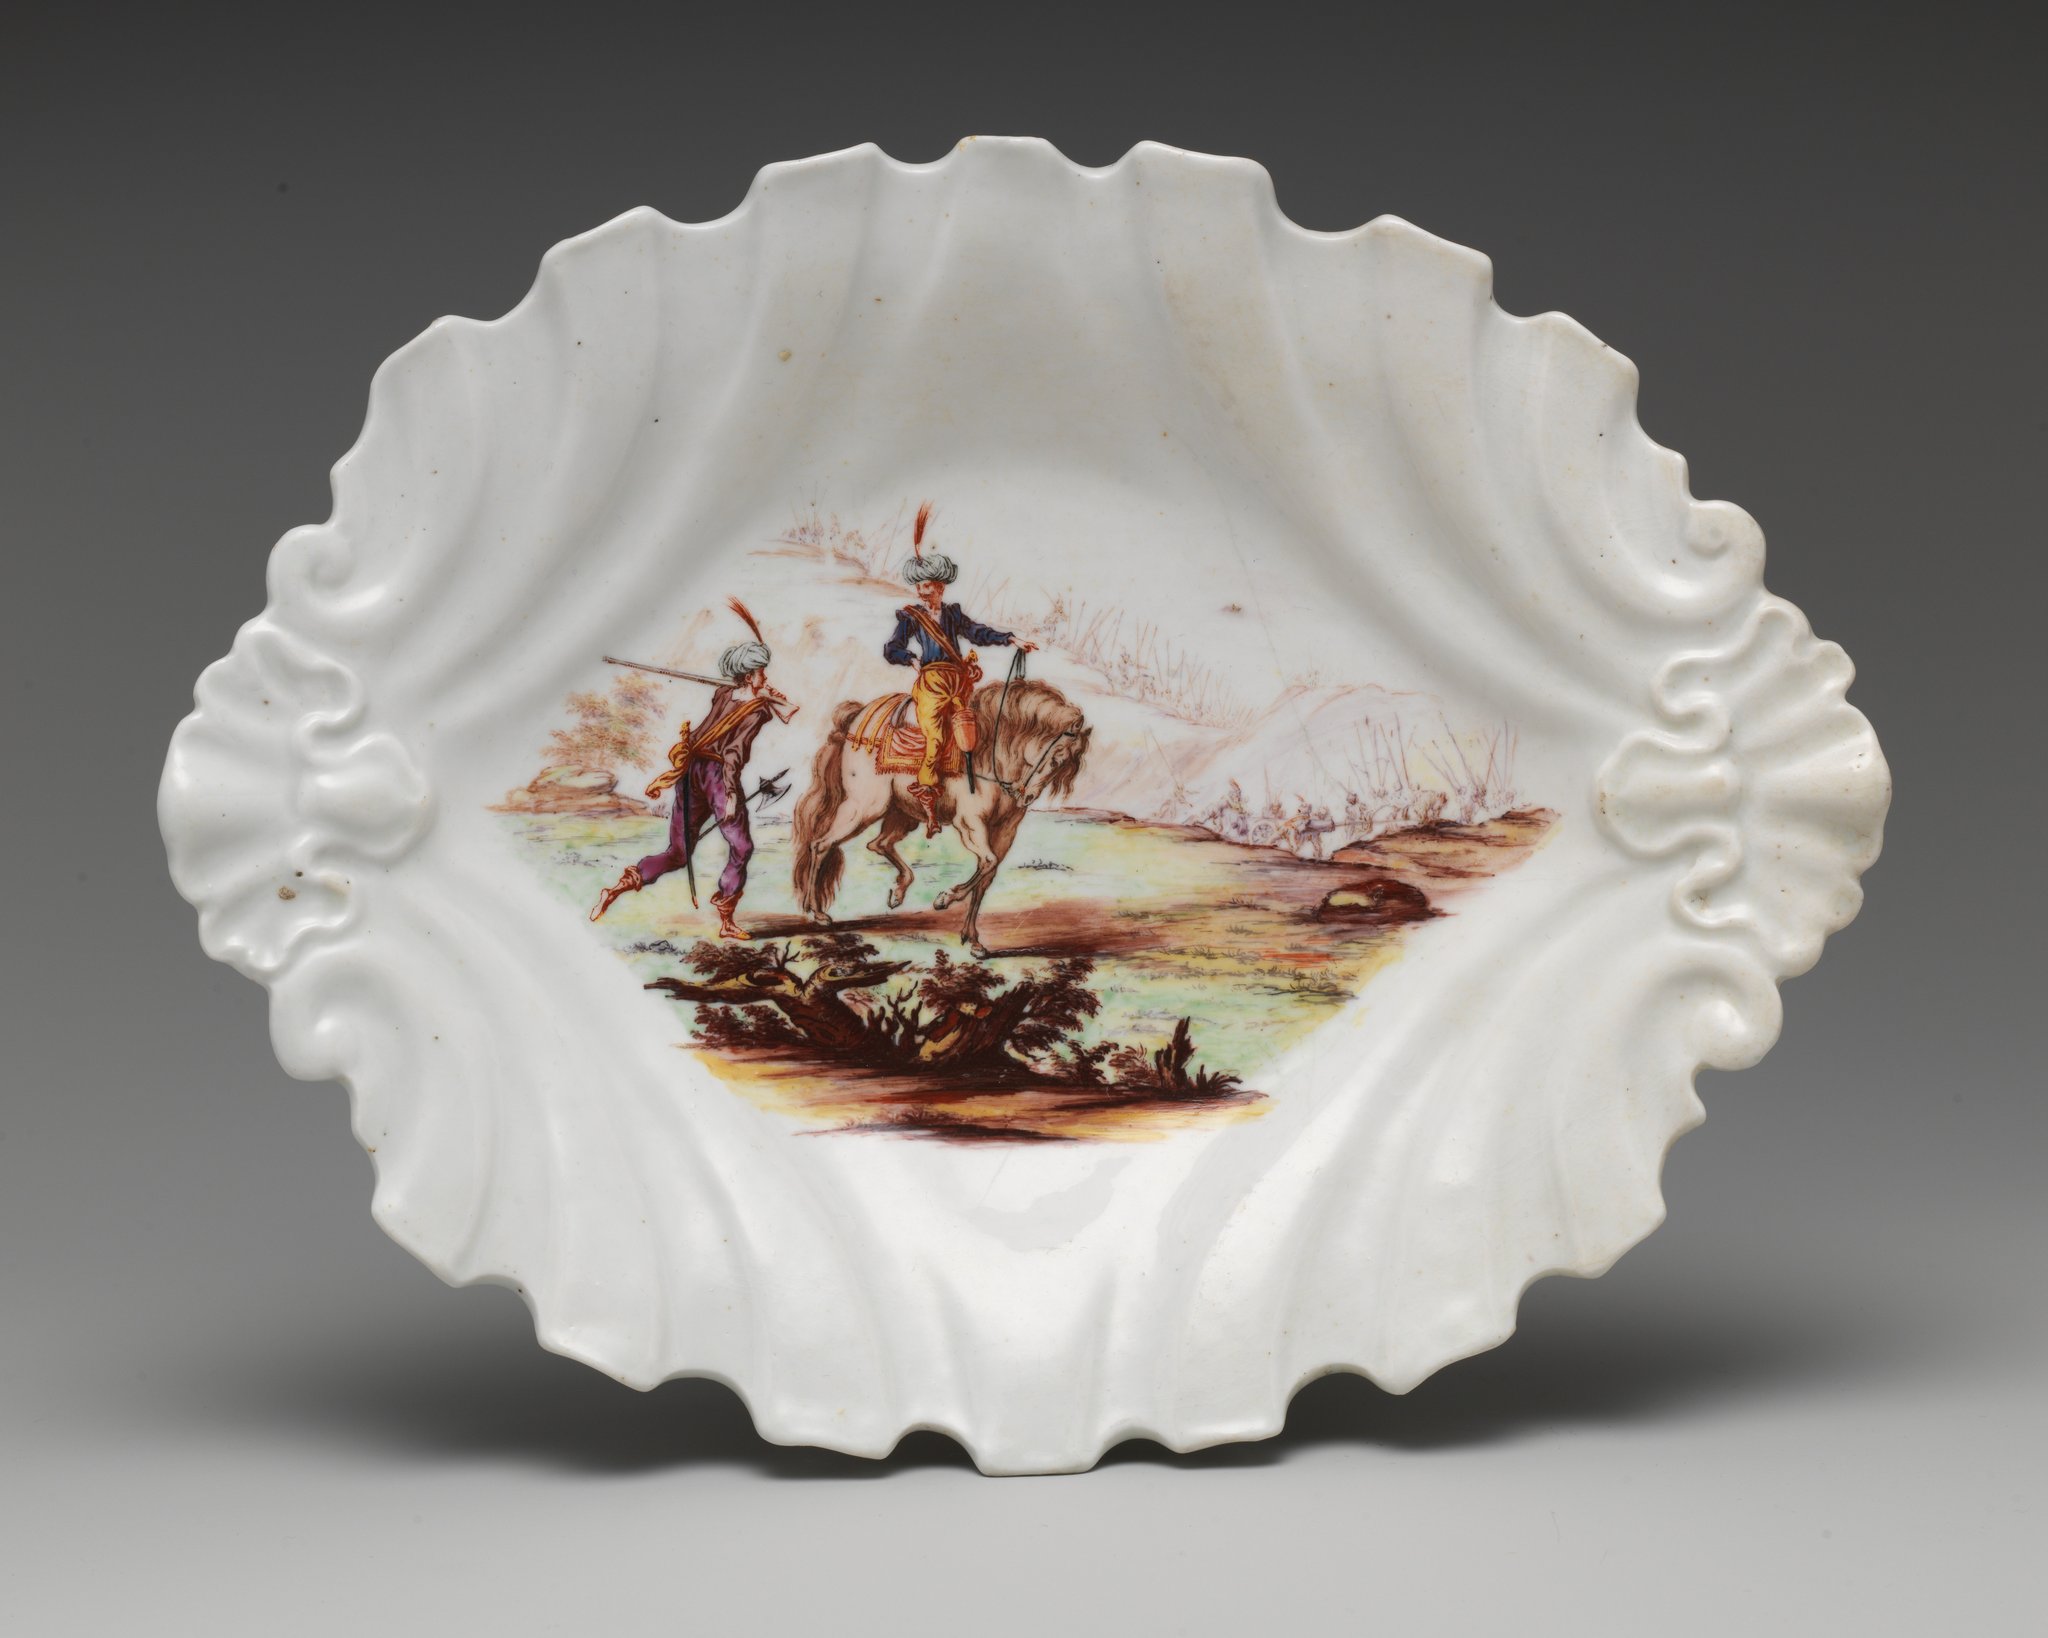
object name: dish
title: Dish (part of a set)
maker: chelsea porcelain manufactory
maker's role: factory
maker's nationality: british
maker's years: 1744-1784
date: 1752-1755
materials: soft paste porcelain